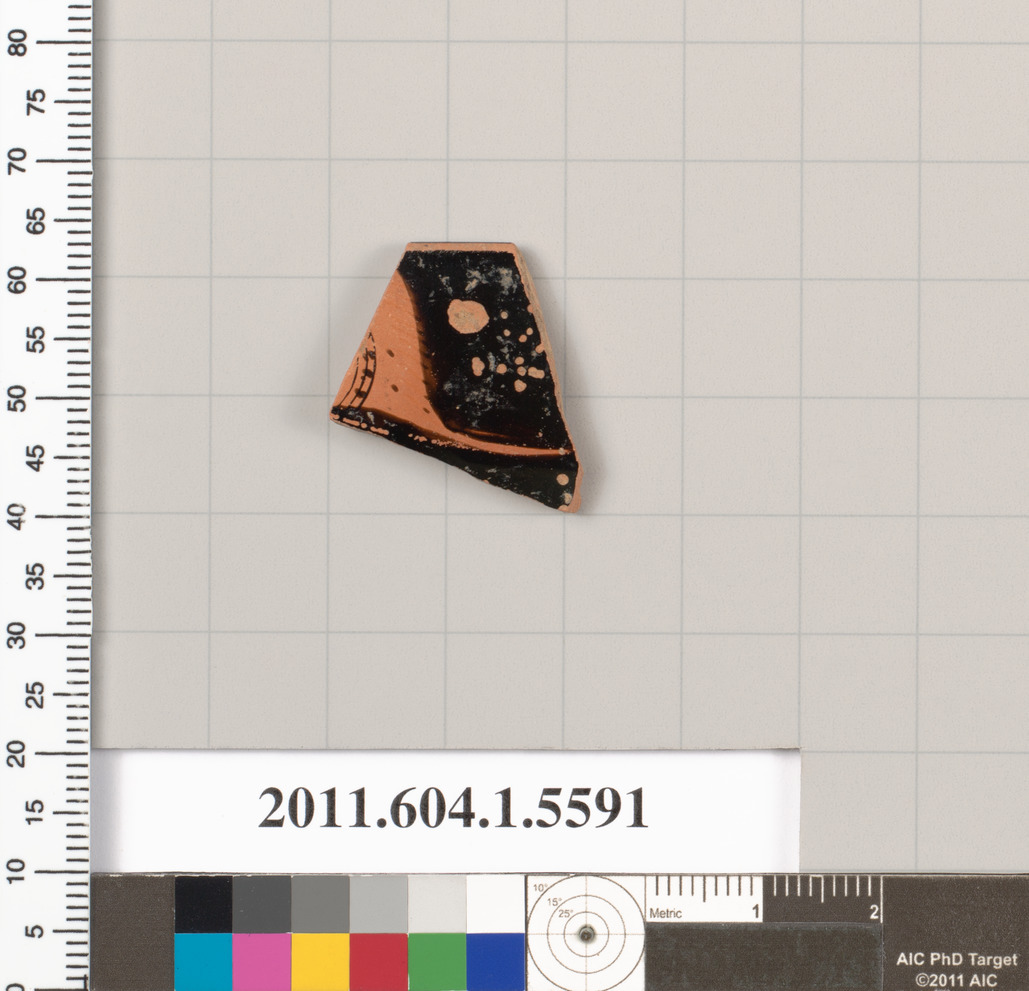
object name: kylix fragment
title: Terracotta rim fragment of a kylix (drinking cup)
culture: greek, attic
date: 510-480 BCE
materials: terracotta